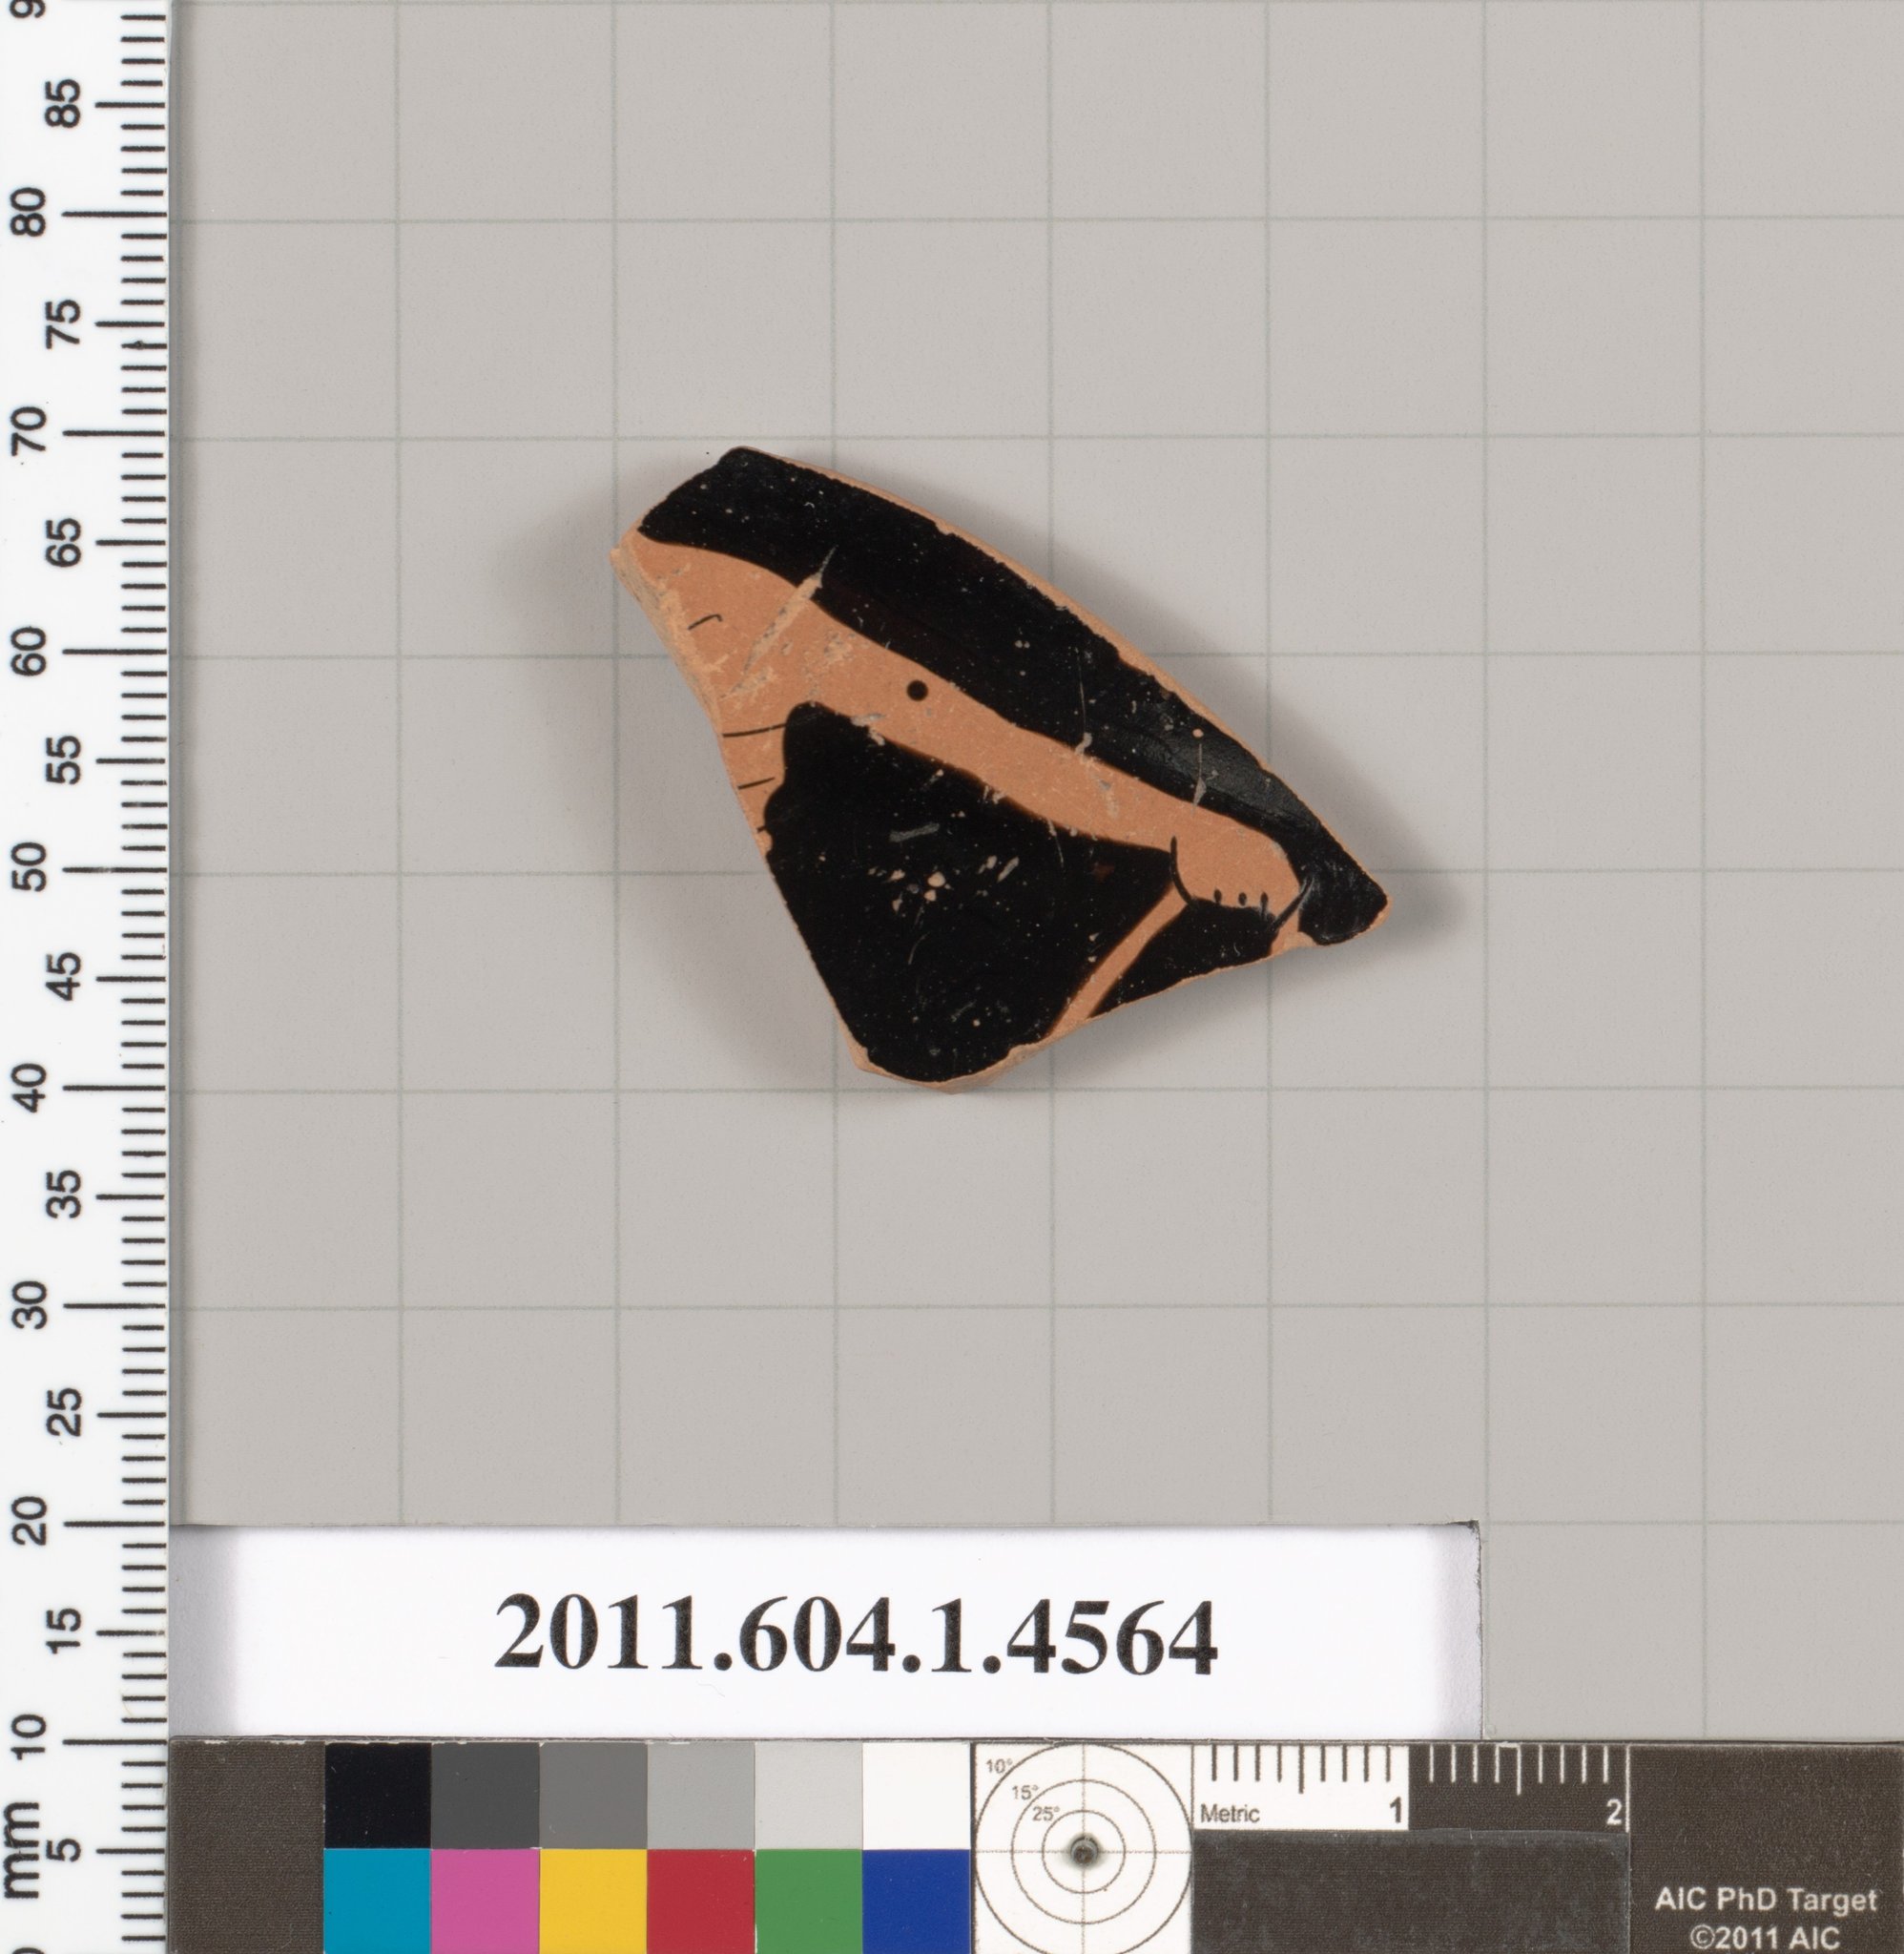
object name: kylix fragment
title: Terracotta fragment of a kylix (drinking cup)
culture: greek, attic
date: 475-451 BCE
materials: terracotta